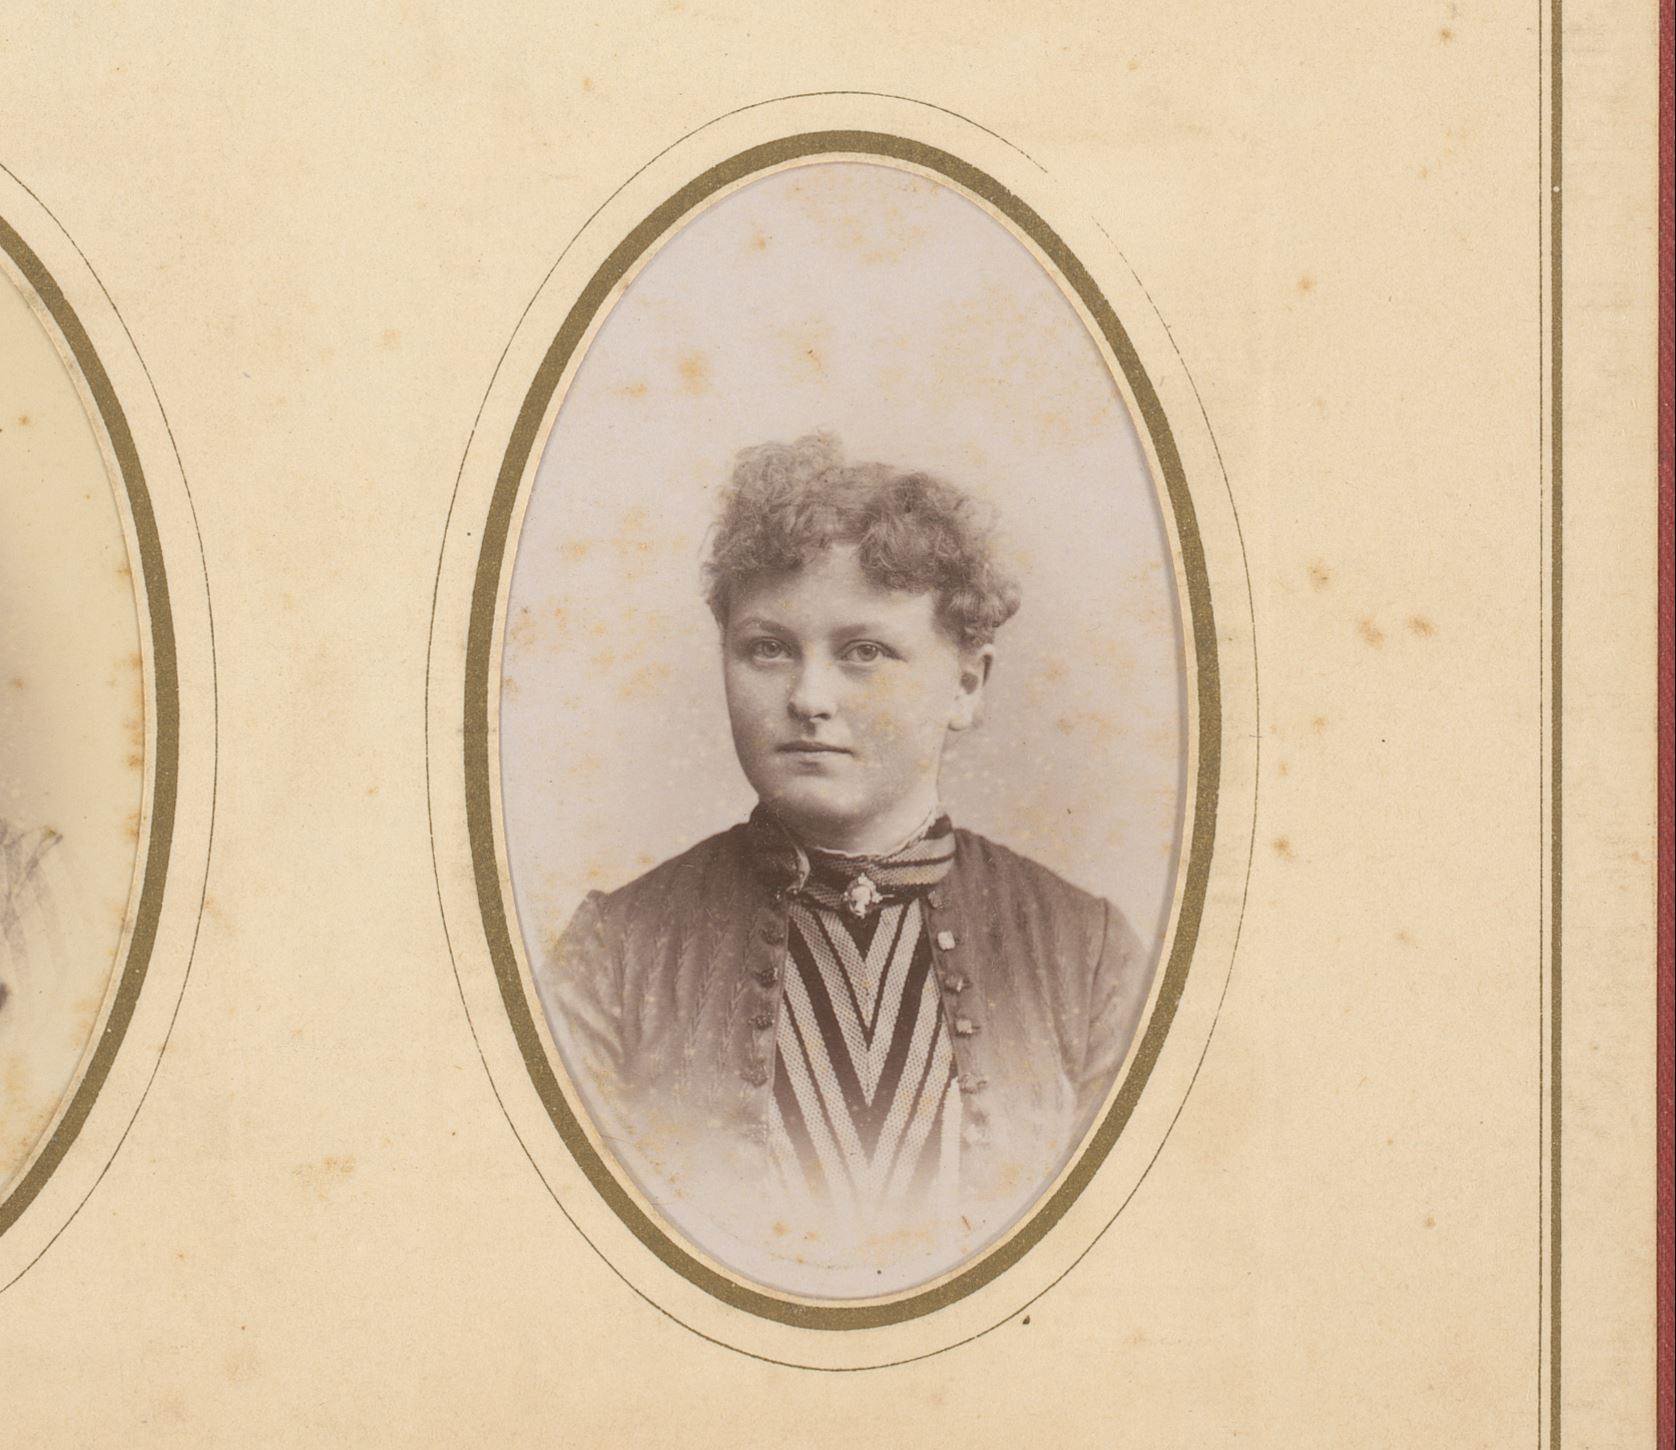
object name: album leaf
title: Portret van een vrouw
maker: friedrich julius von kolkow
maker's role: fotograaf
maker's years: 1839-1914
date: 1876-1900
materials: cardboard, photographic support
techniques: albumen print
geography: groningen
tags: historical persons - bb - woman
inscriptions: inscription: ‘(...)/ Fr. Jul von Kolkow/ Koninklyk Nederlandsch Hof-Photograph/ (...)/ GRONINGEN/ Groote Markt by de/ Martinitoorn./ Specialiteit in Vergrootingen’